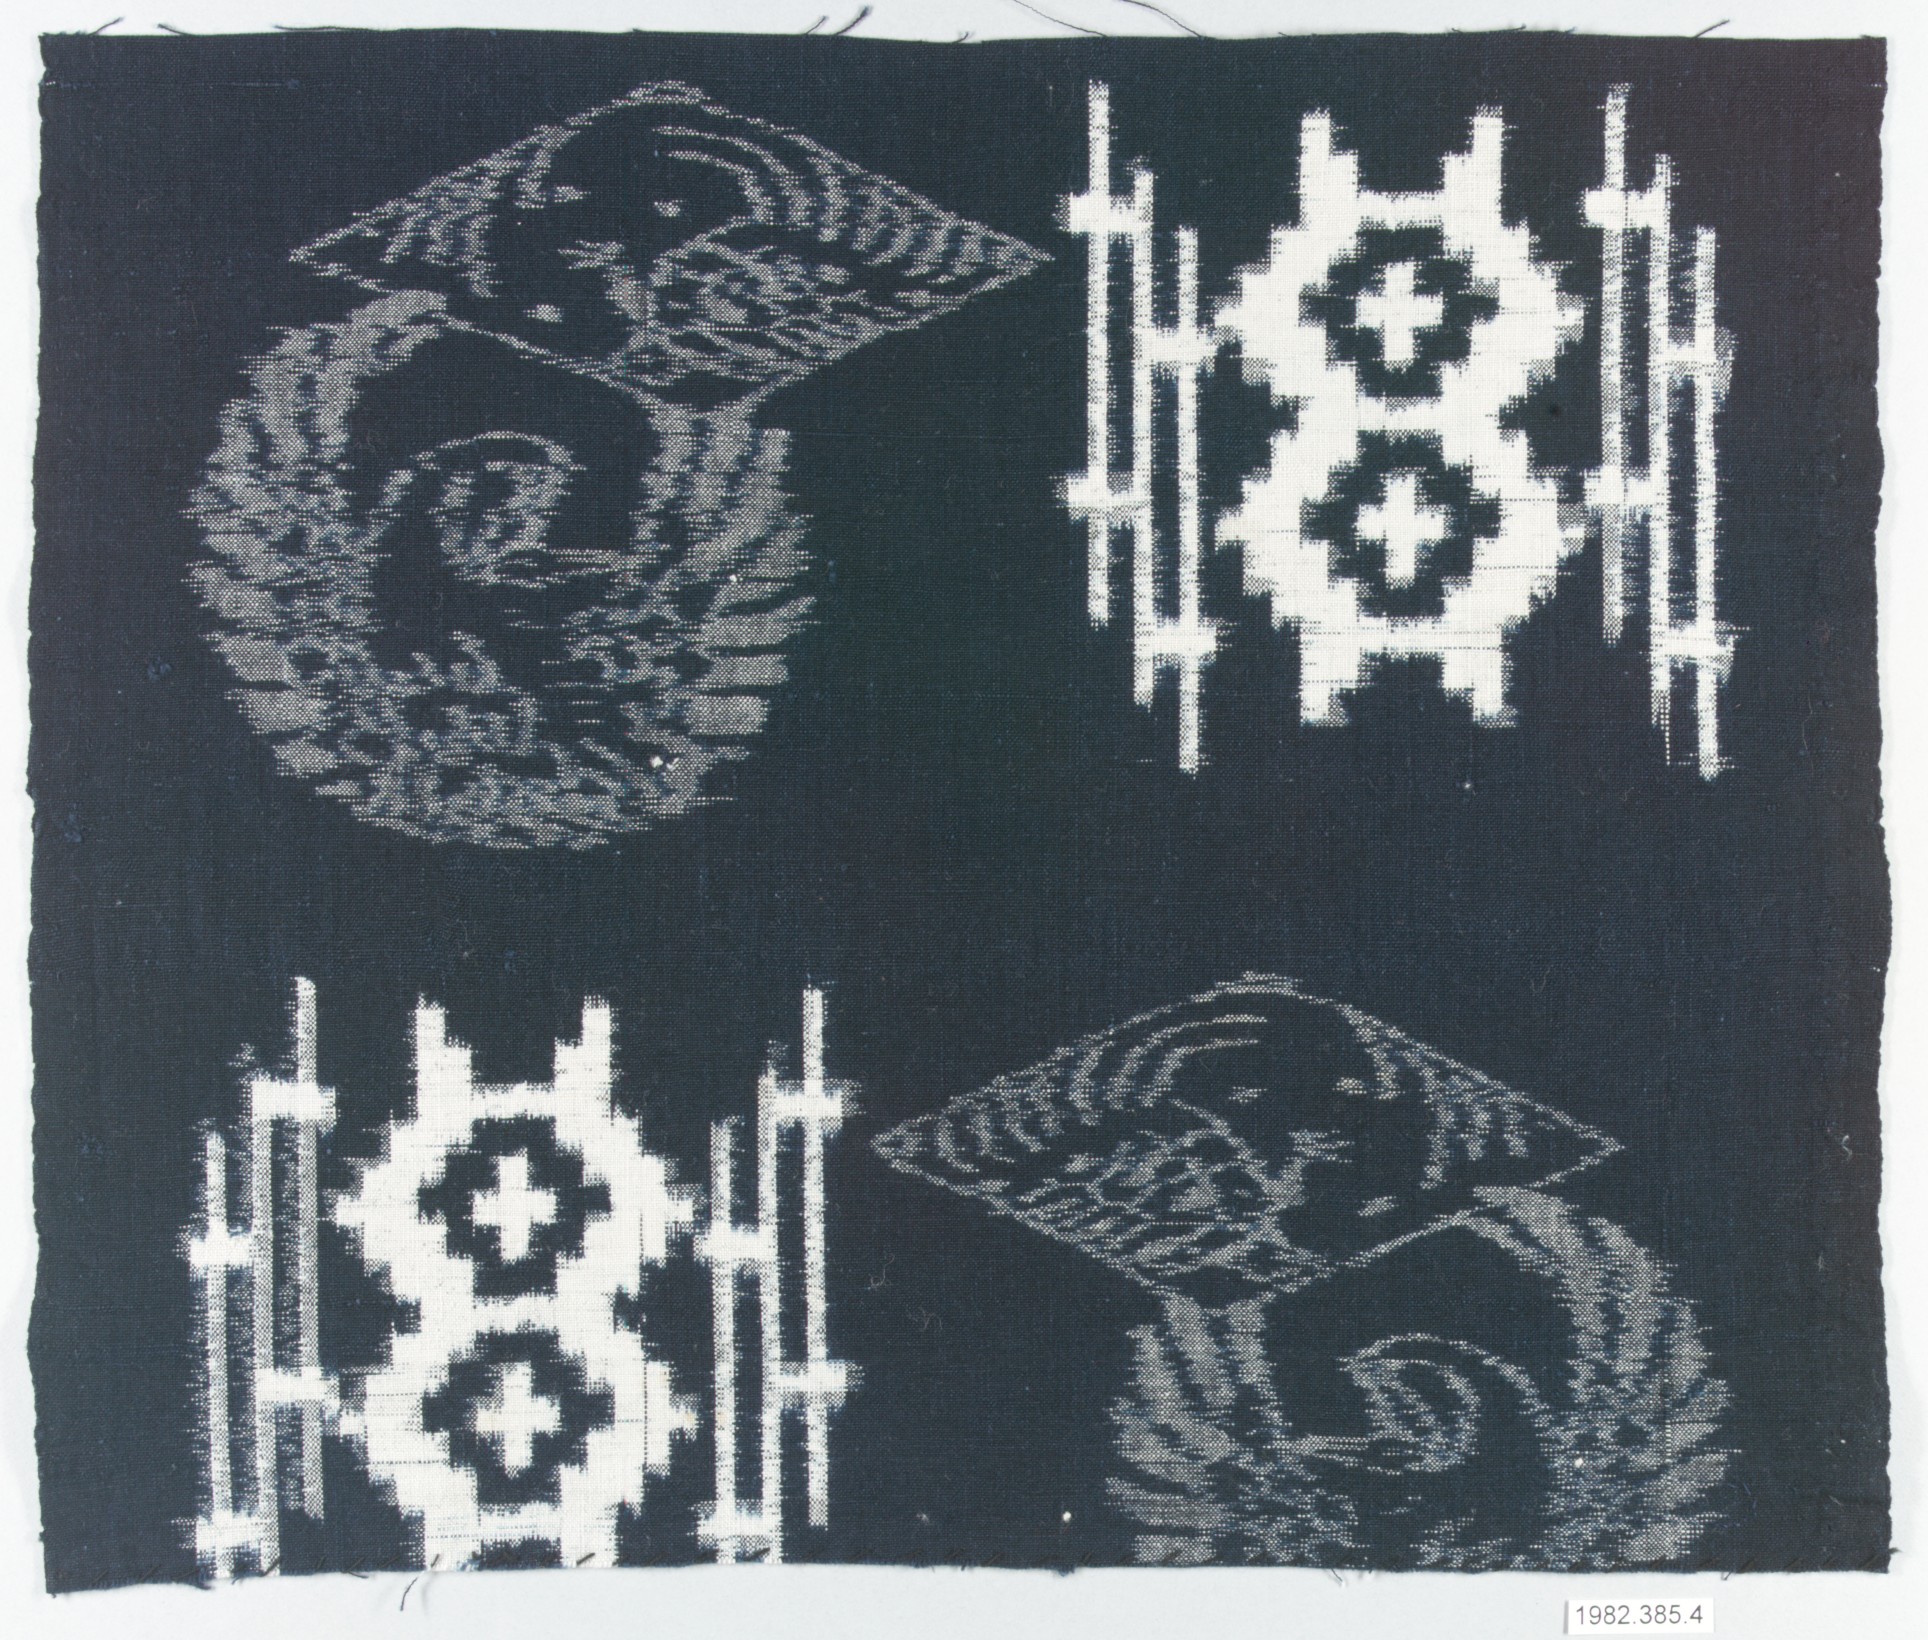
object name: piece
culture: japanese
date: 1868-1926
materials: cotton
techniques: dyeing